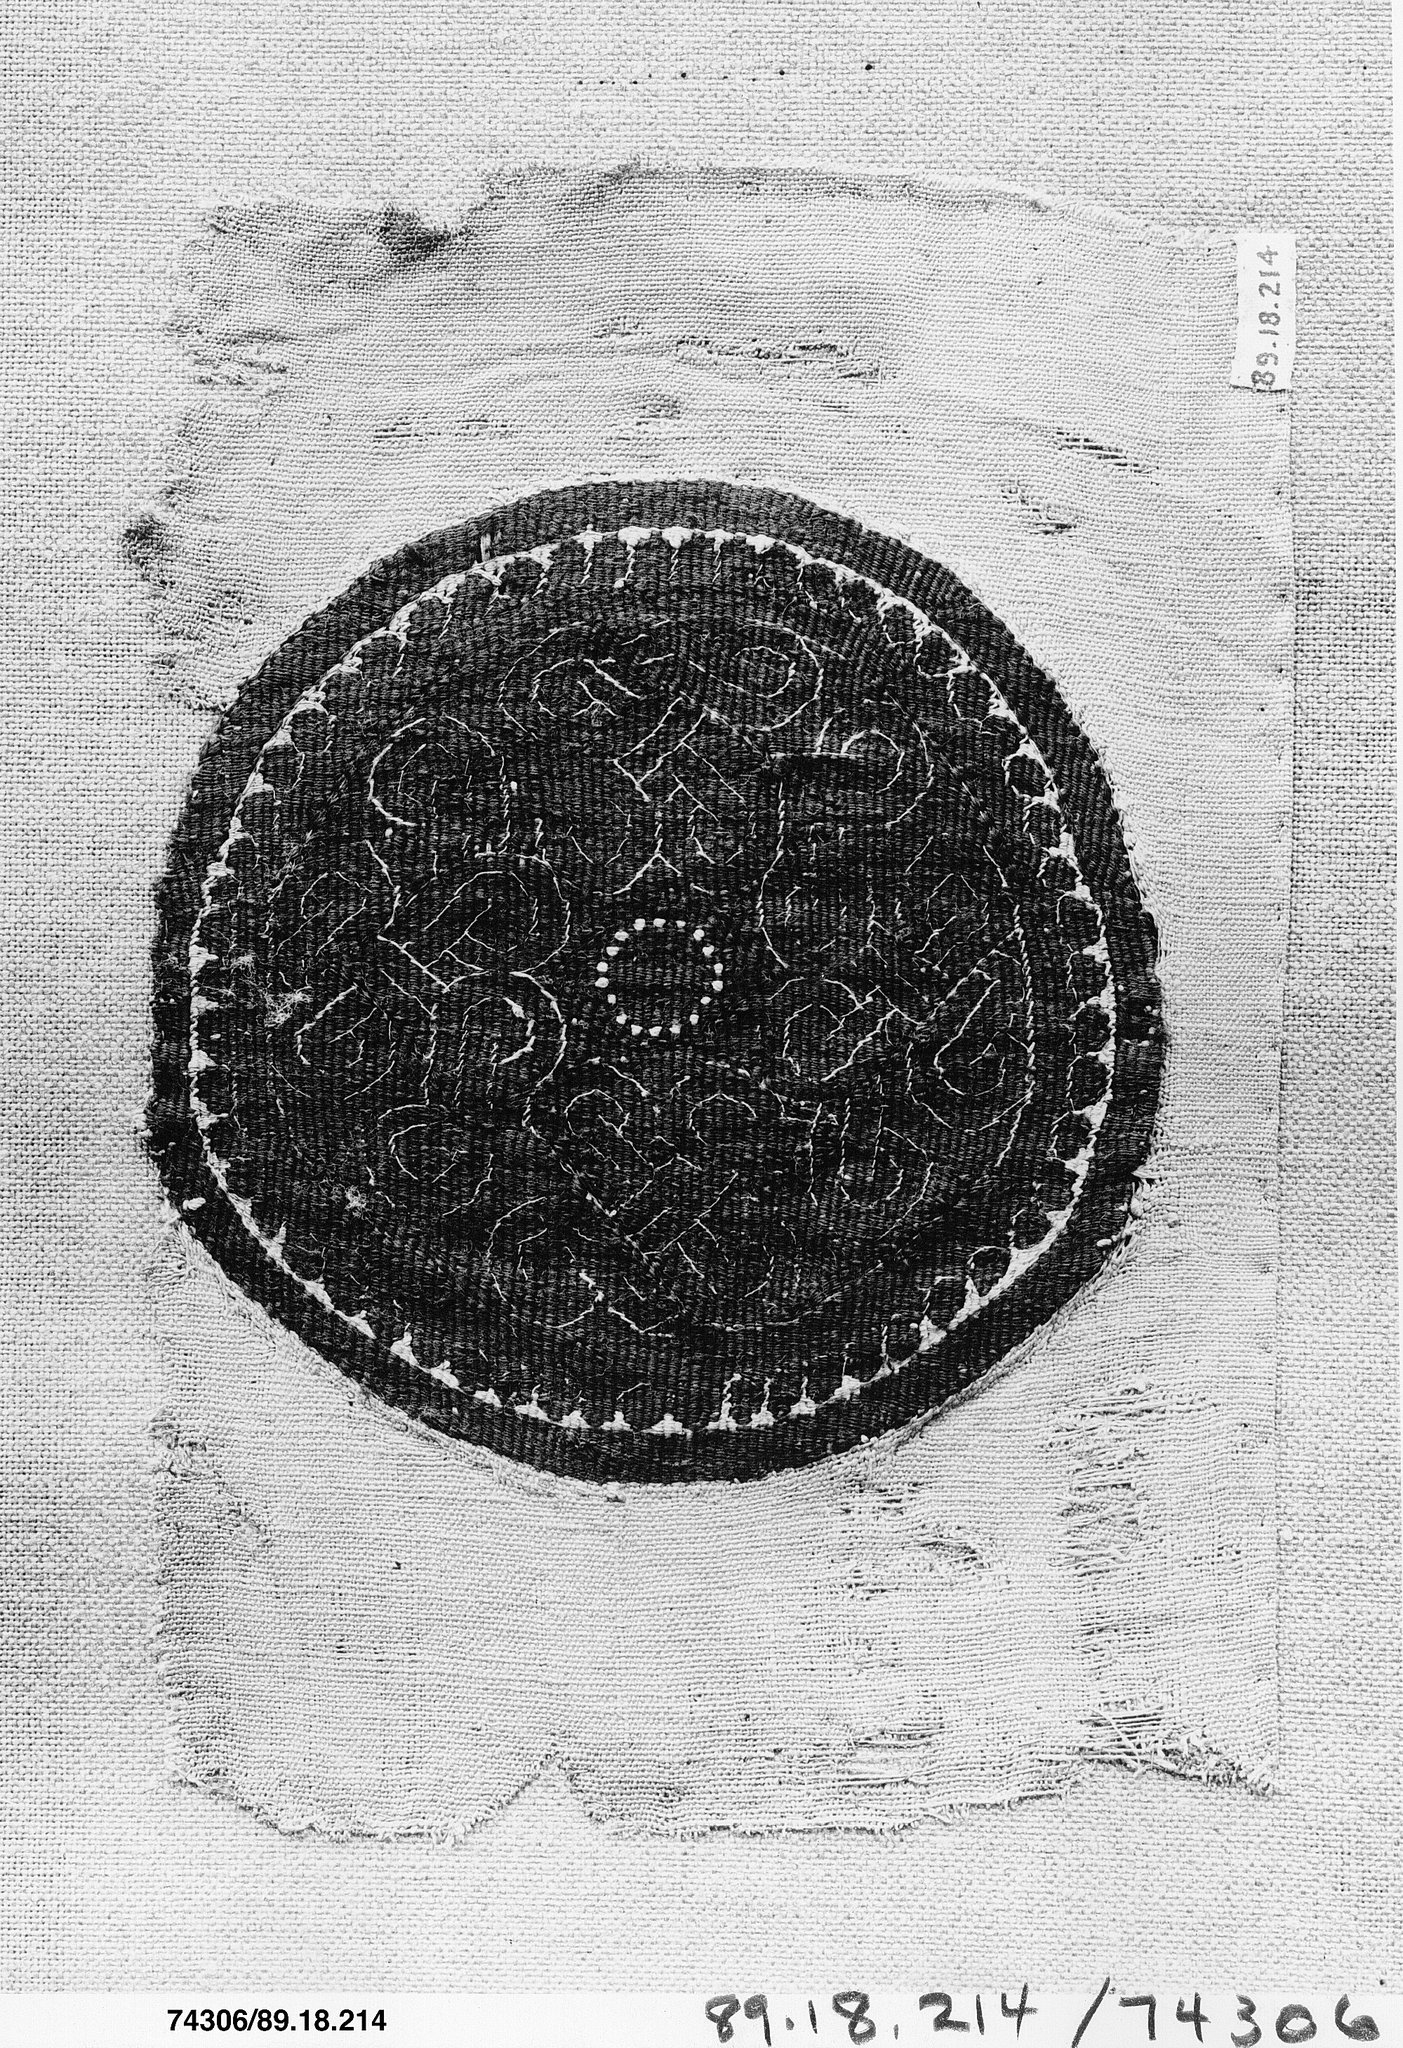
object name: textile fragment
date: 201-400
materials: linen, wool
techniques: weave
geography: egypt